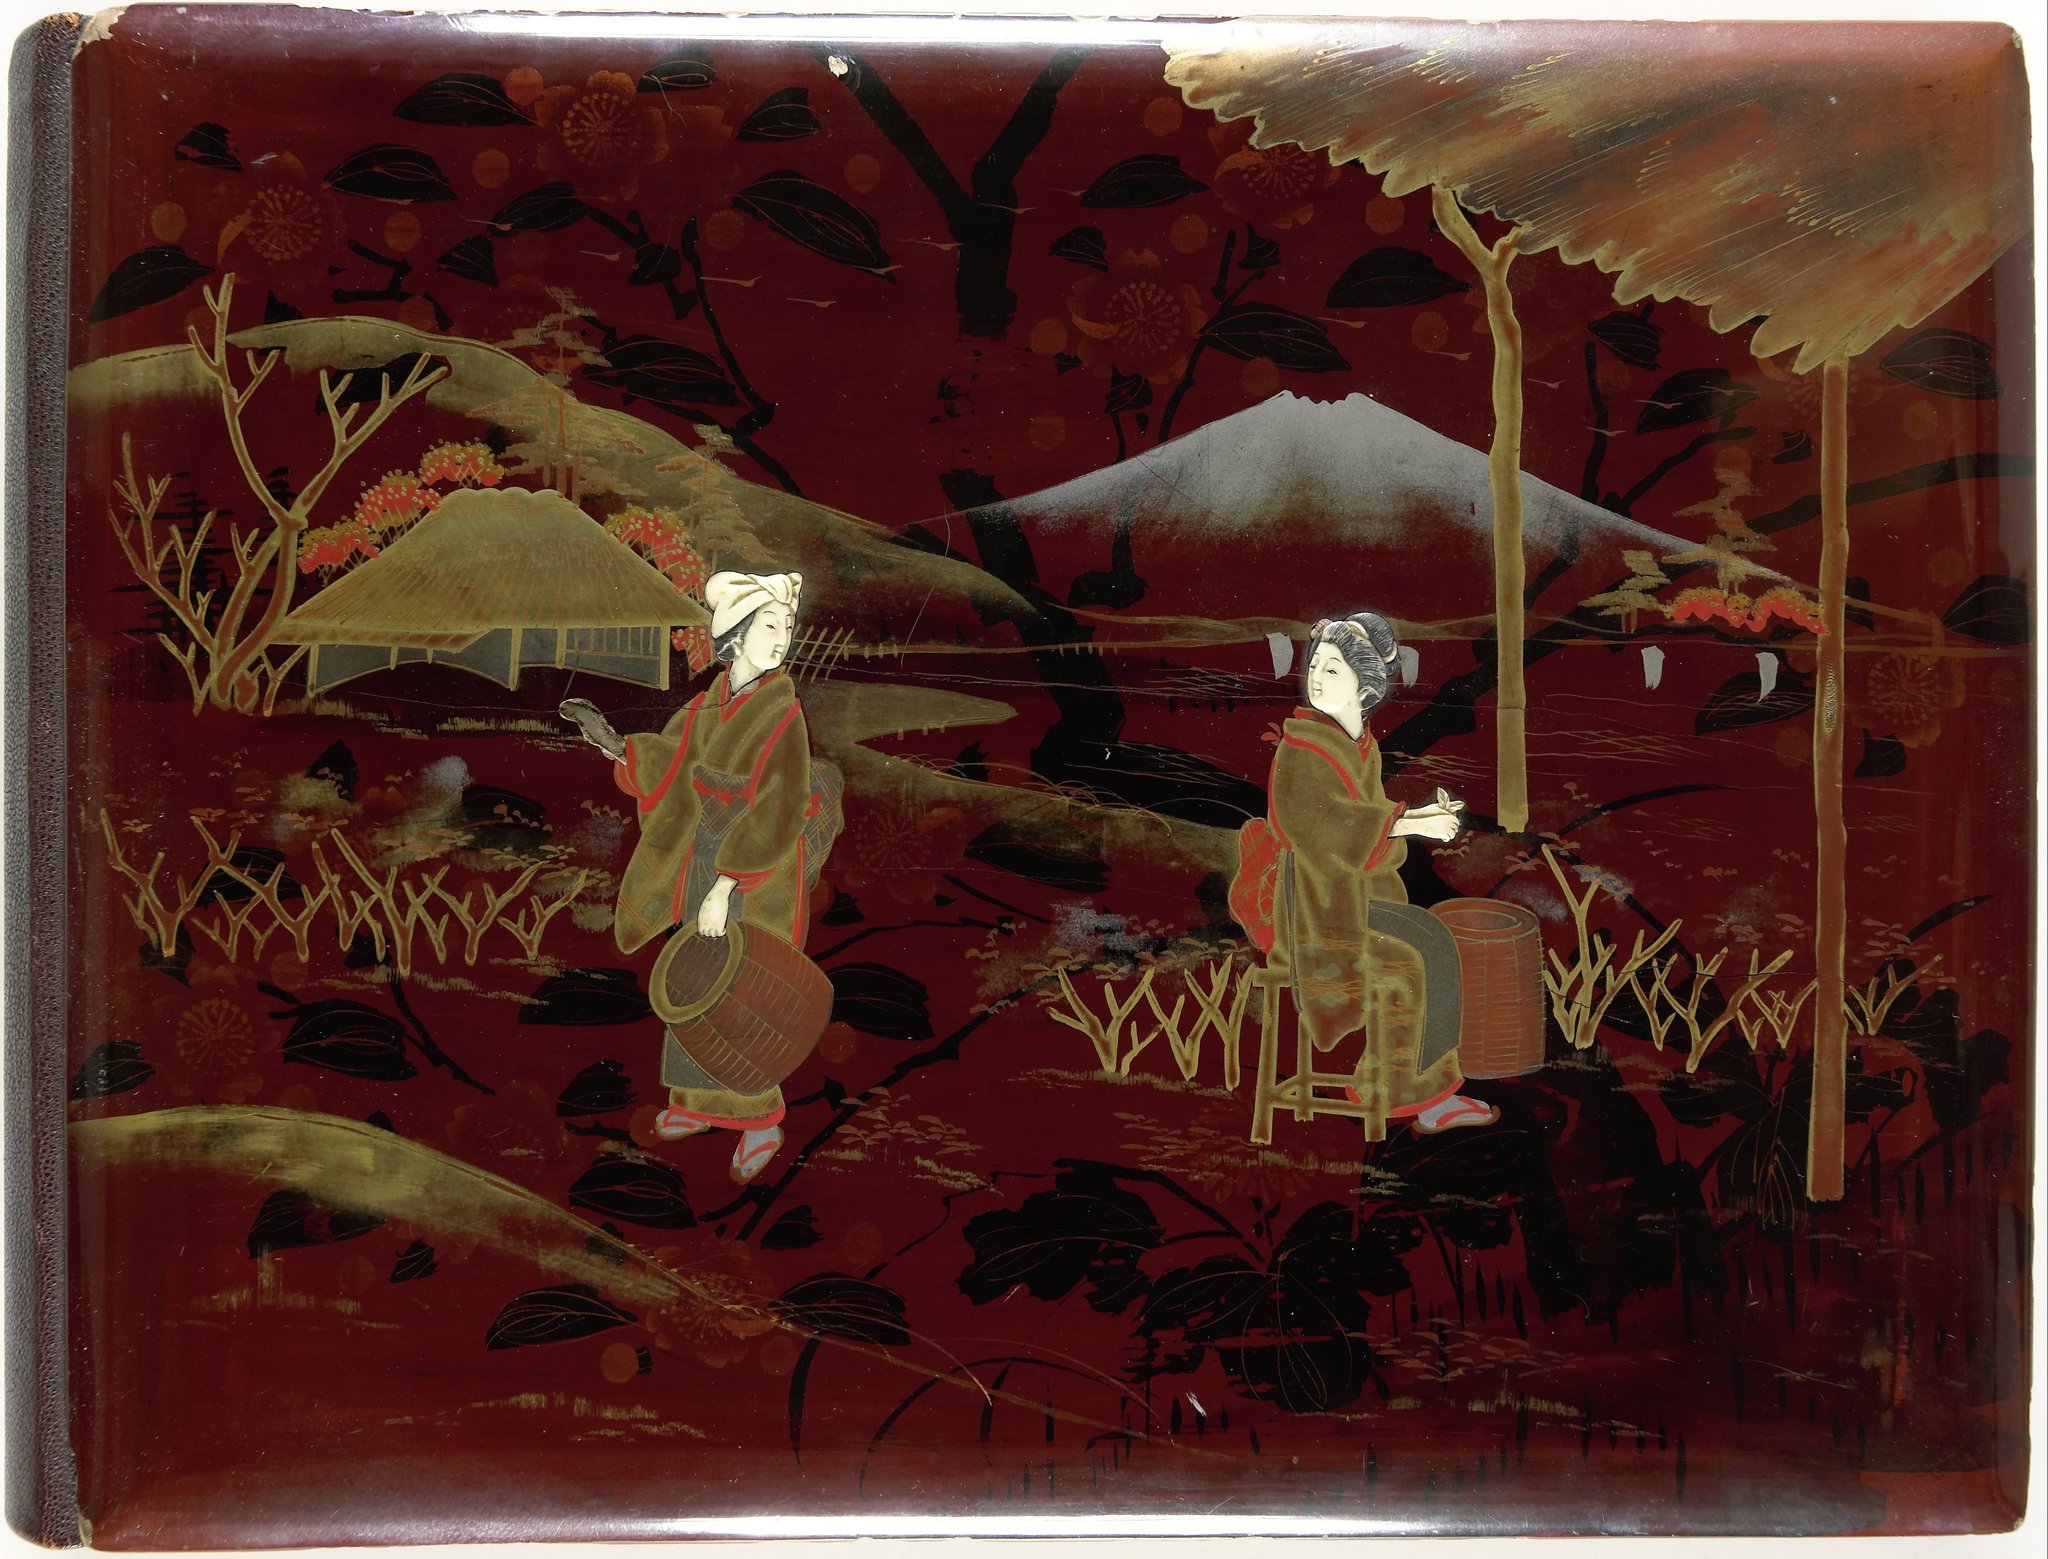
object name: photograph album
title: Fotoalbum van Lucie Sandel, ca. 1903-1907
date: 1903-1907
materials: cardboard, lacquer, leather, paper, photographic support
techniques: albumen print, gelatin silver print, platinum process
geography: sumatra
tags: sumatra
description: Fotoalbum met Cantonese lakpanelen met Japanse motieven op voor- en achterzijde. Het album bevat 25 kartonnen bladen met goud op snee met 58 foto's over het leven van Paul en Lucie Sandel in Langkat op Sumatra in de periode ca. 1903-1907.